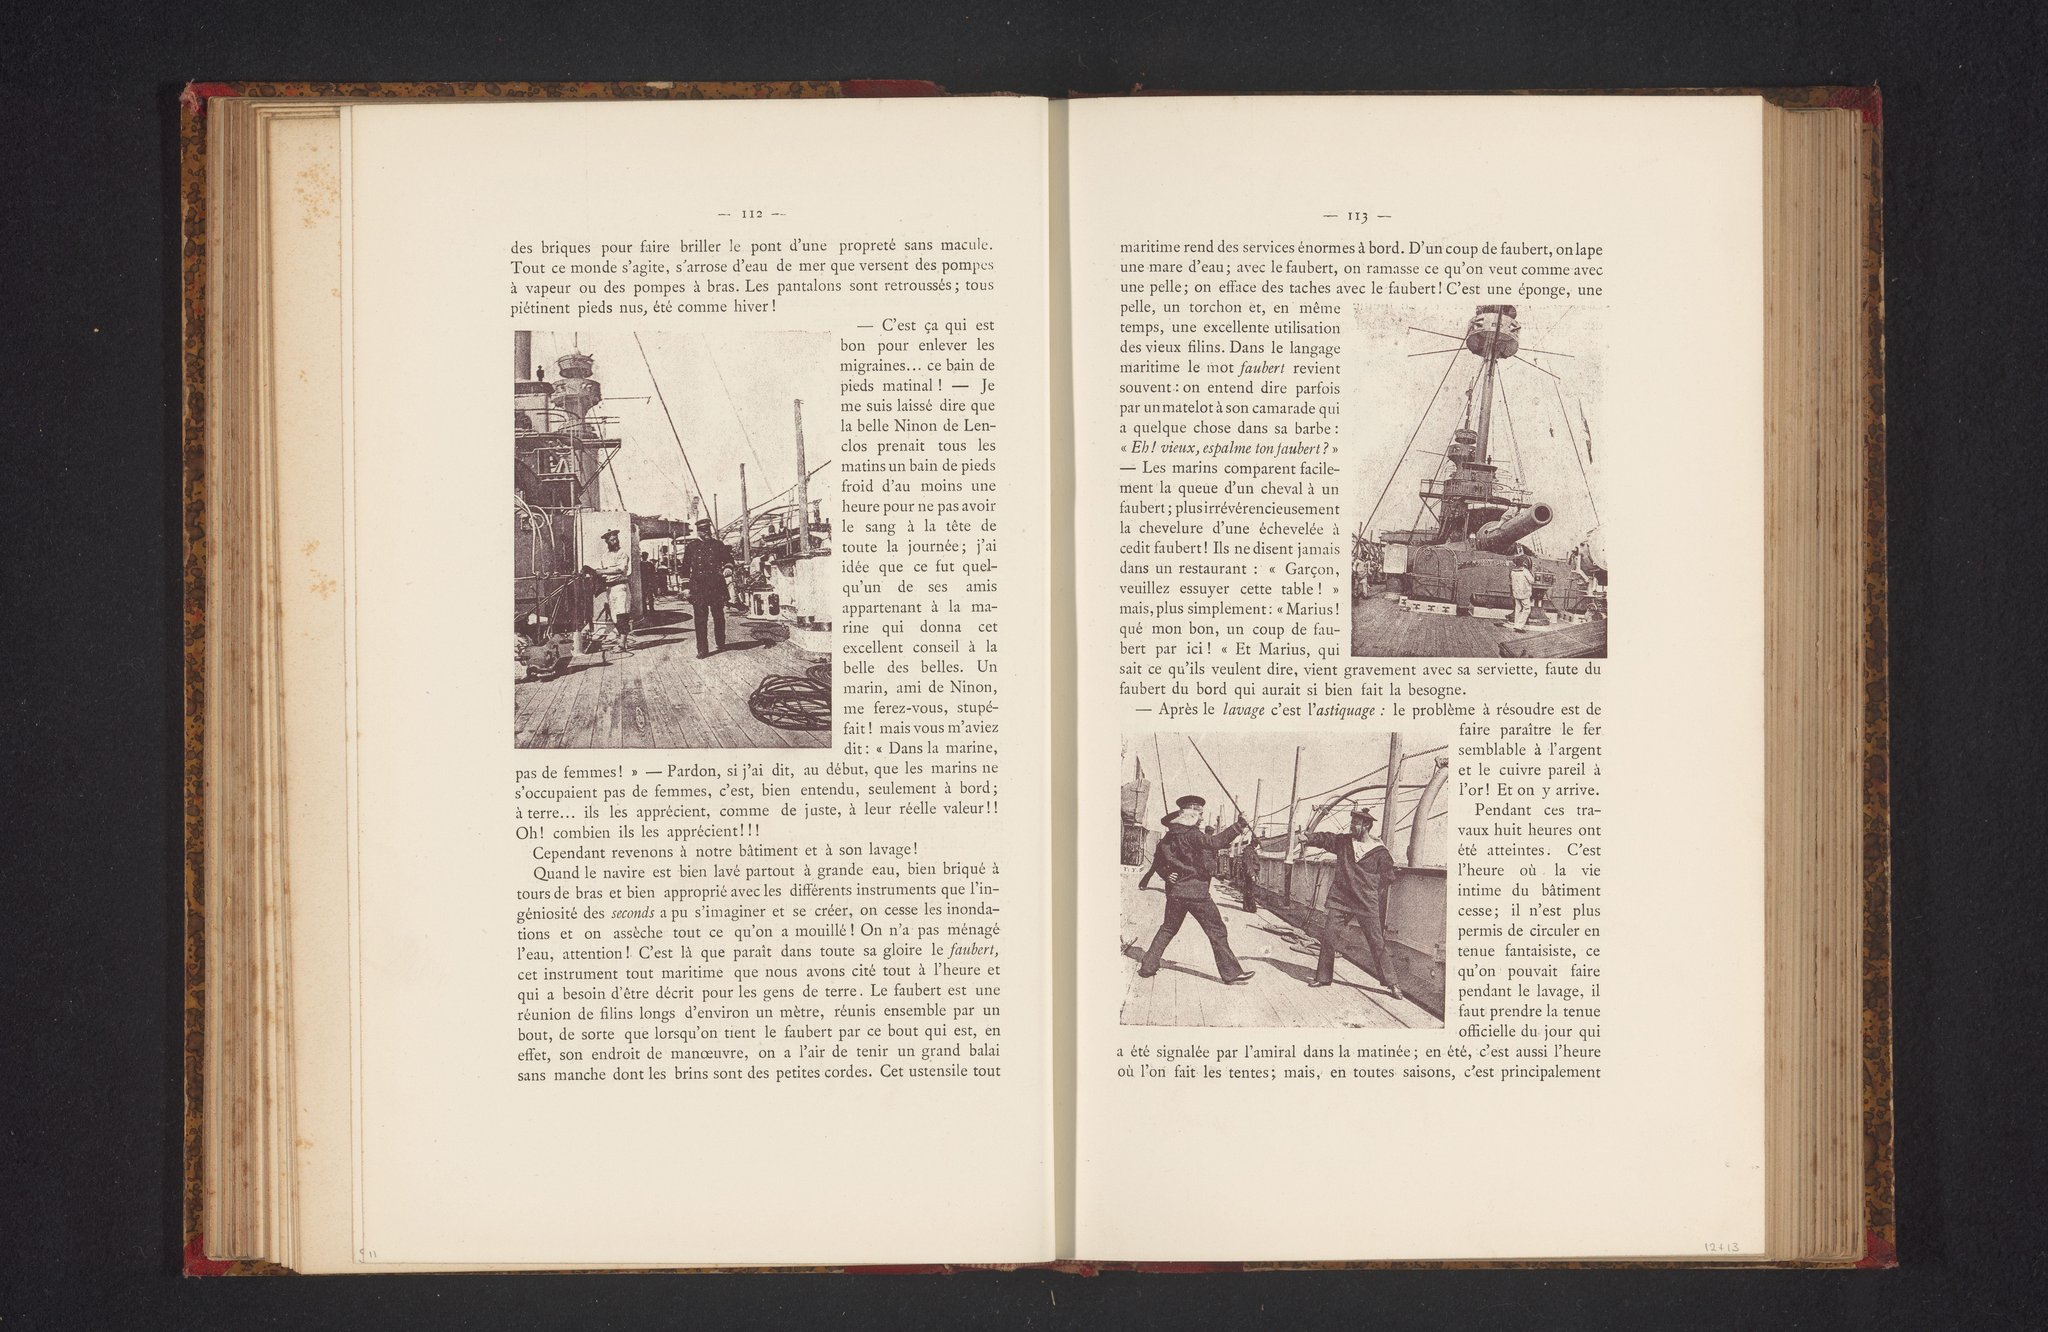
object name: photomechanical print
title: De kapitein aan dek van een oorlogsschip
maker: Anonymous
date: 1888-1893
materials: paper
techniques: photograph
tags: crew ~ ship, seaman (with name of rank), (military) equipment and supply, steamship, motorship